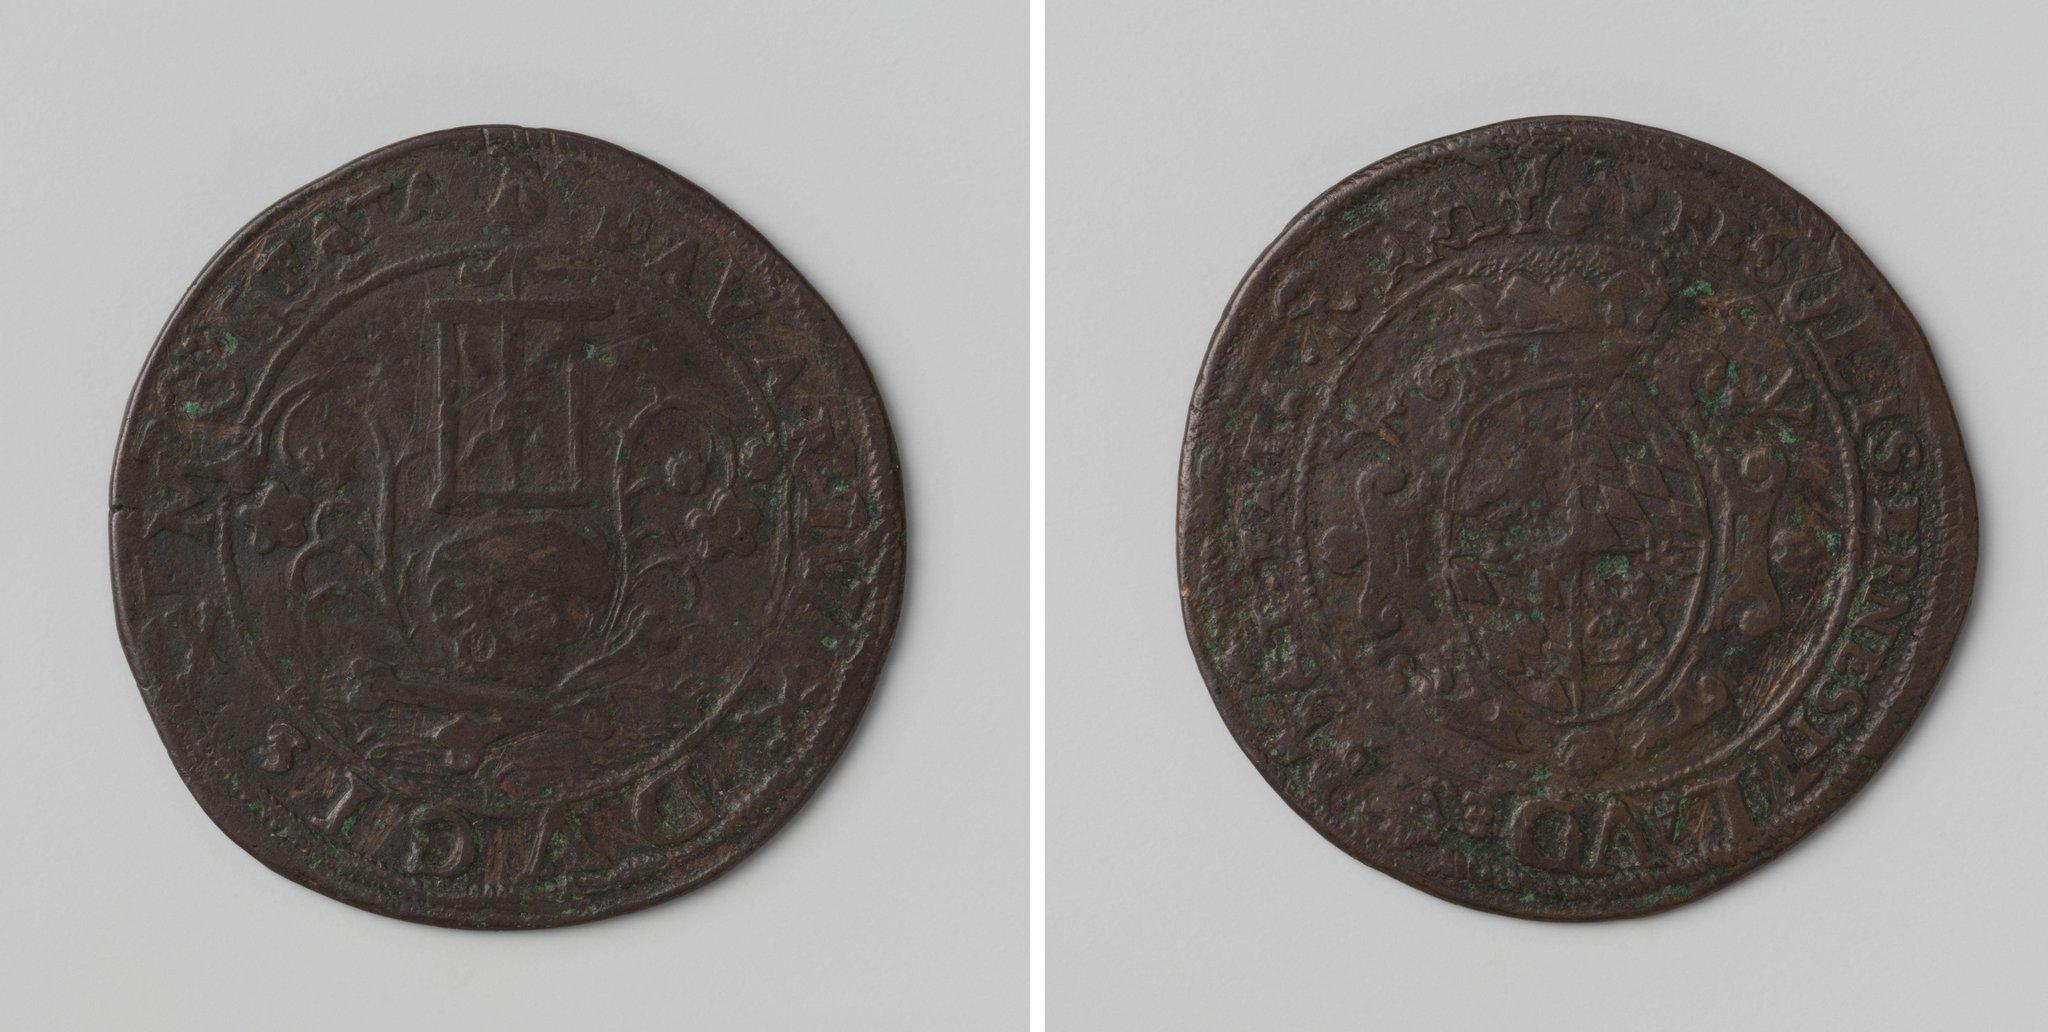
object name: jeton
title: Overlijden van Ernst van Beieren, prins-bisschop van Luik, aartsbisschop van Keulen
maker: Anonymous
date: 1612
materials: copper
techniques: striking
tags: ernst van beieren (prins-bisschop van luik), liège, cologne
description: Koperen penning. Voorzijde: doodshoofd op twee gekruiste beenderen, bekroond met zandloper tussen twee bloeiende planten binnen omschrift. Keerzijde: gekroond wapenschild op cartouche binnen omschrift